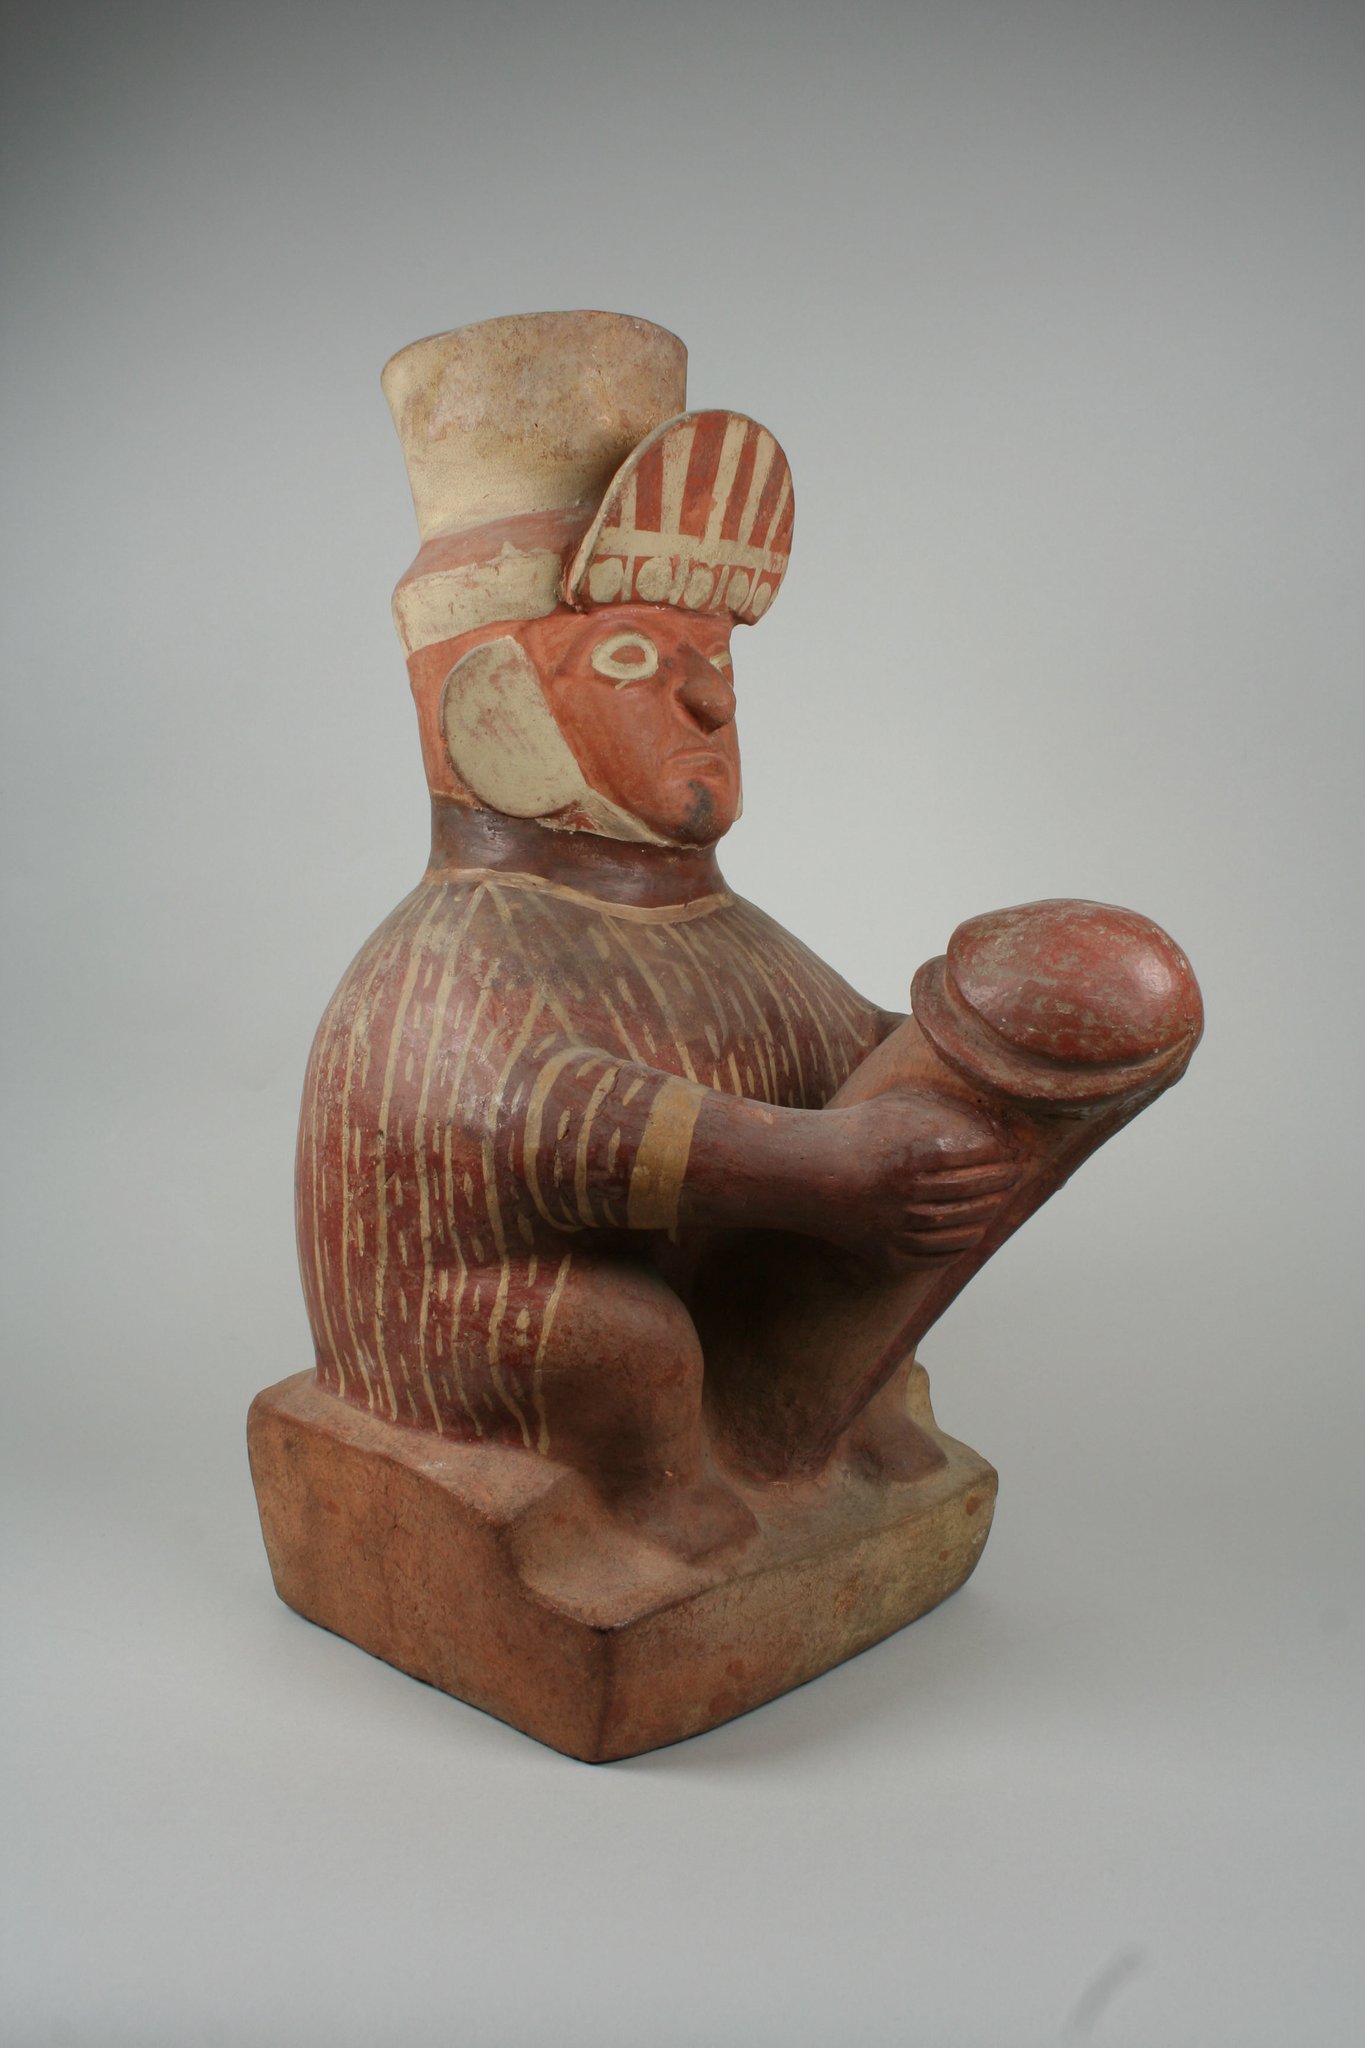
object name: bottle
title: Stirrup Spout Bottle with Phallic Figure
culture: moche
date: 201-600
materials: ceramic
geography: peru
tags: male nudes